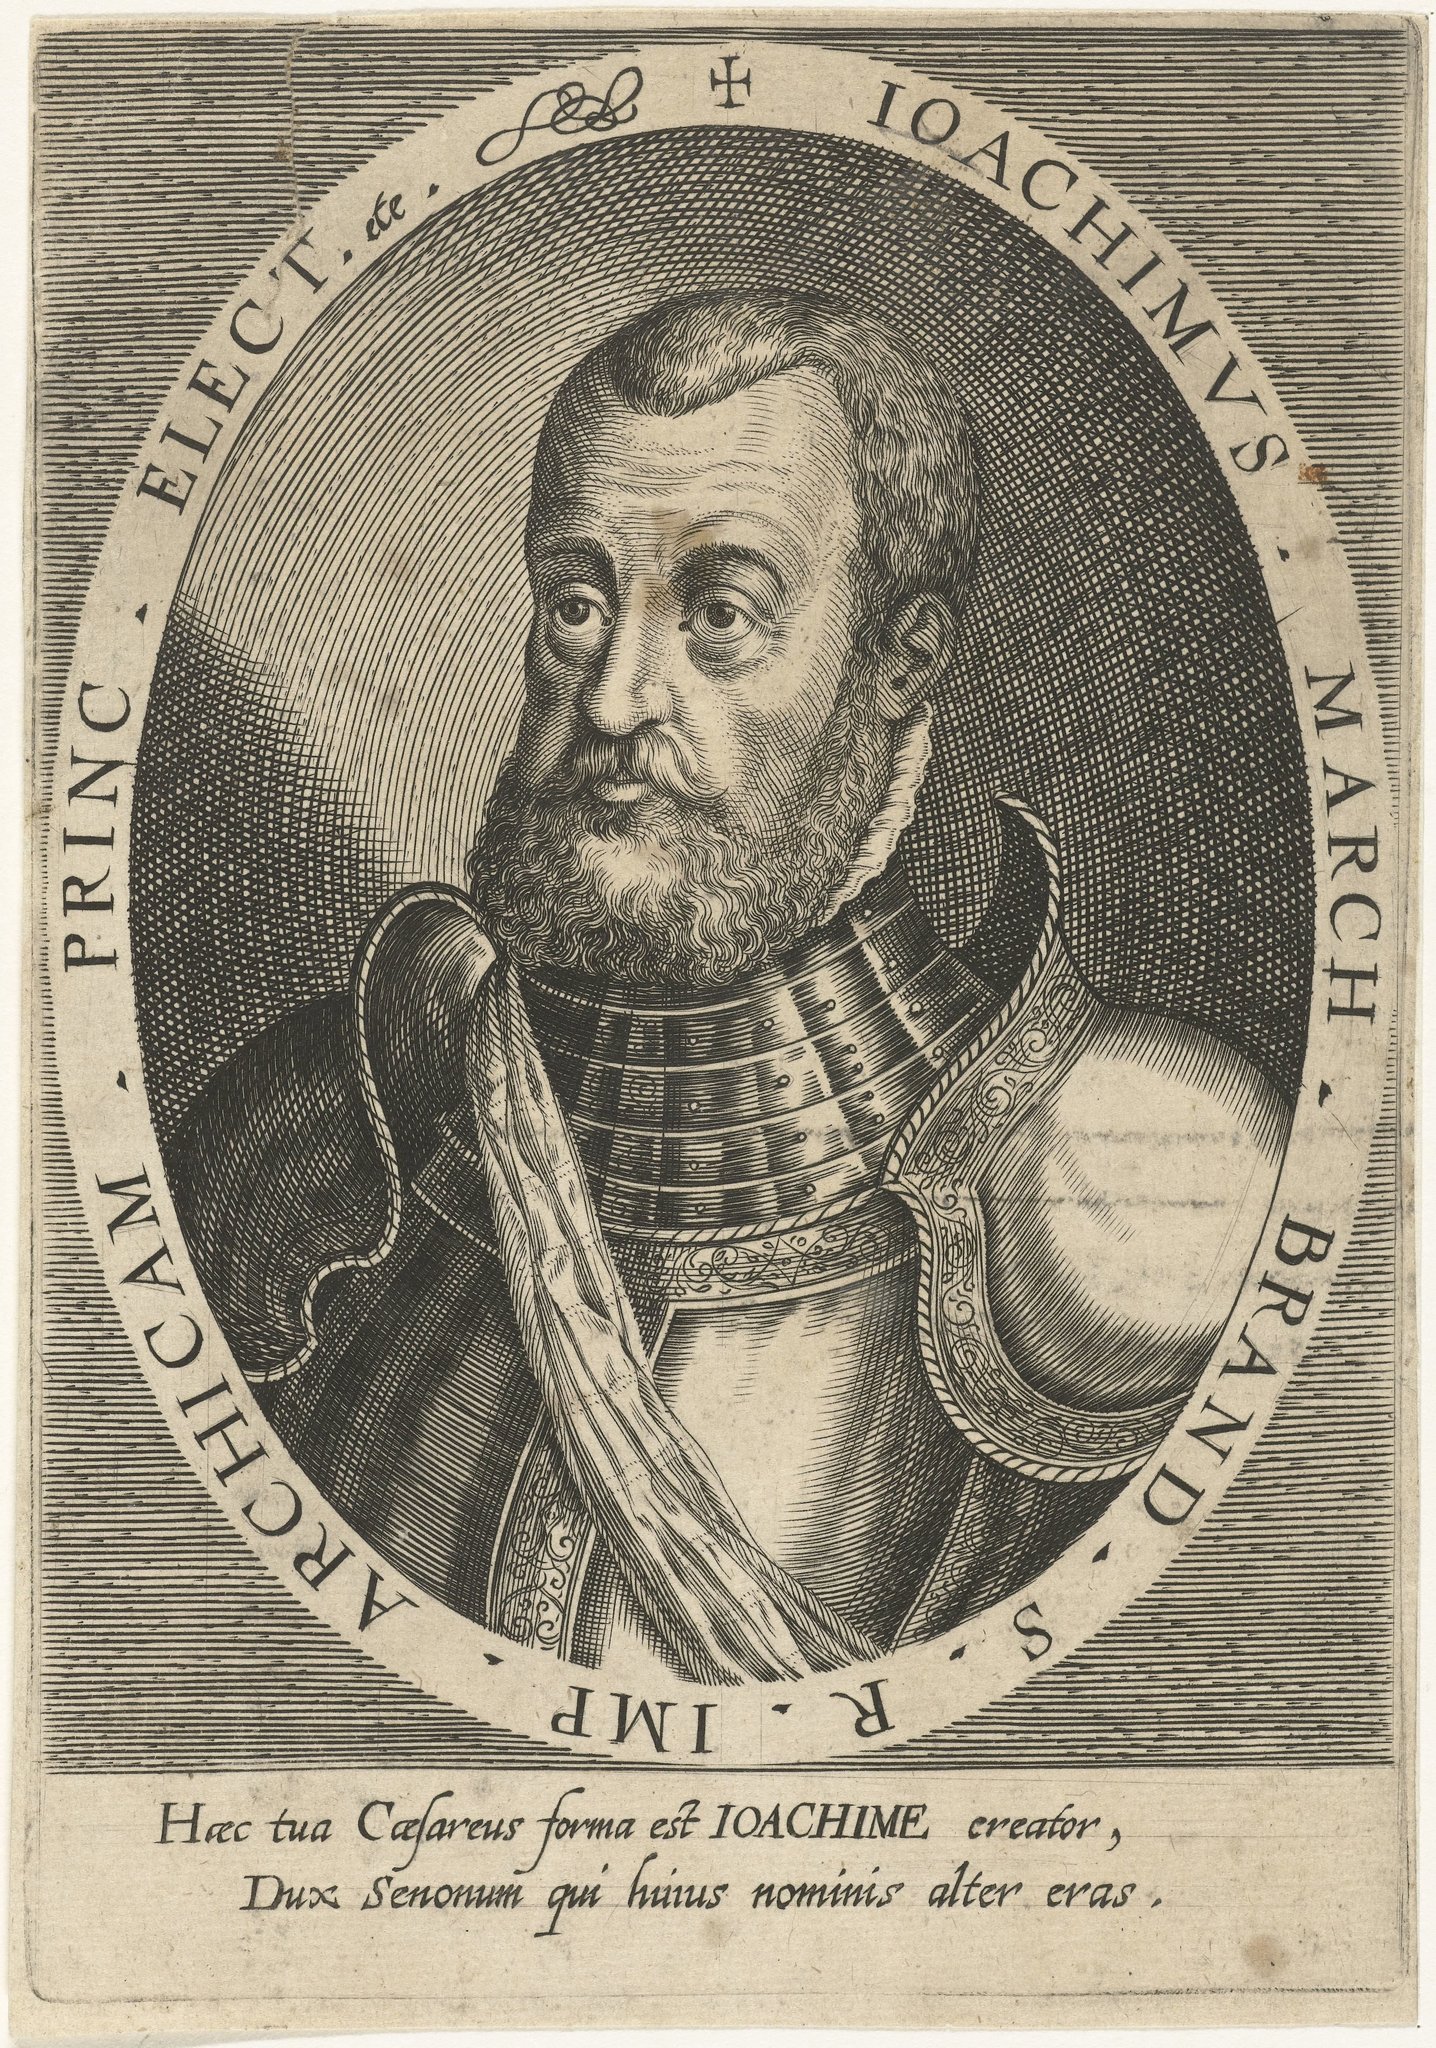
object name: print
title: Portret van Joachim II keurvorst van Brandenburg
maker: dominicus custos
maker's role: print maker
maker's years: 1560-1615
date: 1600-1604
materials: paper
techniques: engraving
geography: augsburg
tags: keurvorst van brandenburg joachim ii hector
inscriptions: collector's mark: Lugt 2228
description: Illustratie uit: D. Custos en M. Henning. Atrium heroicum Caesarum, regum aliorq. summatum ac procerum qui intra proximum seculum vixere, aut hodie supersunt, imaginib. Deel 1-4. Augsburg: D. Custos, 1600-1604.